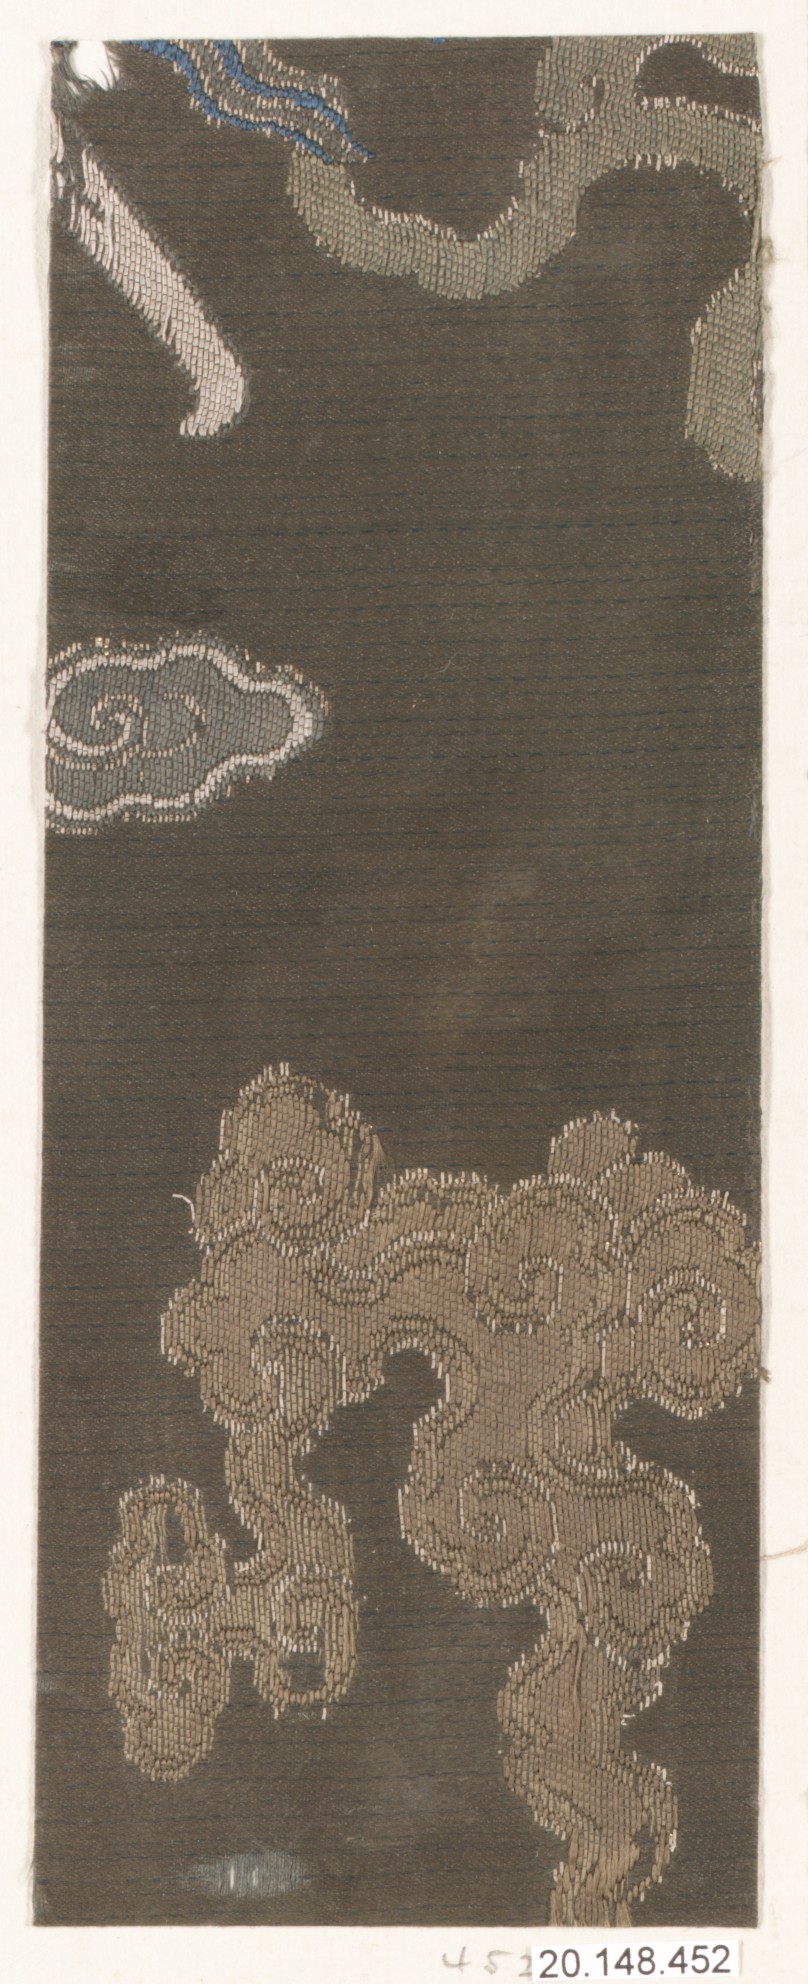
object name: piece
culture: chinese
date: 1701-1800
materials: silk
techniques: compound weave